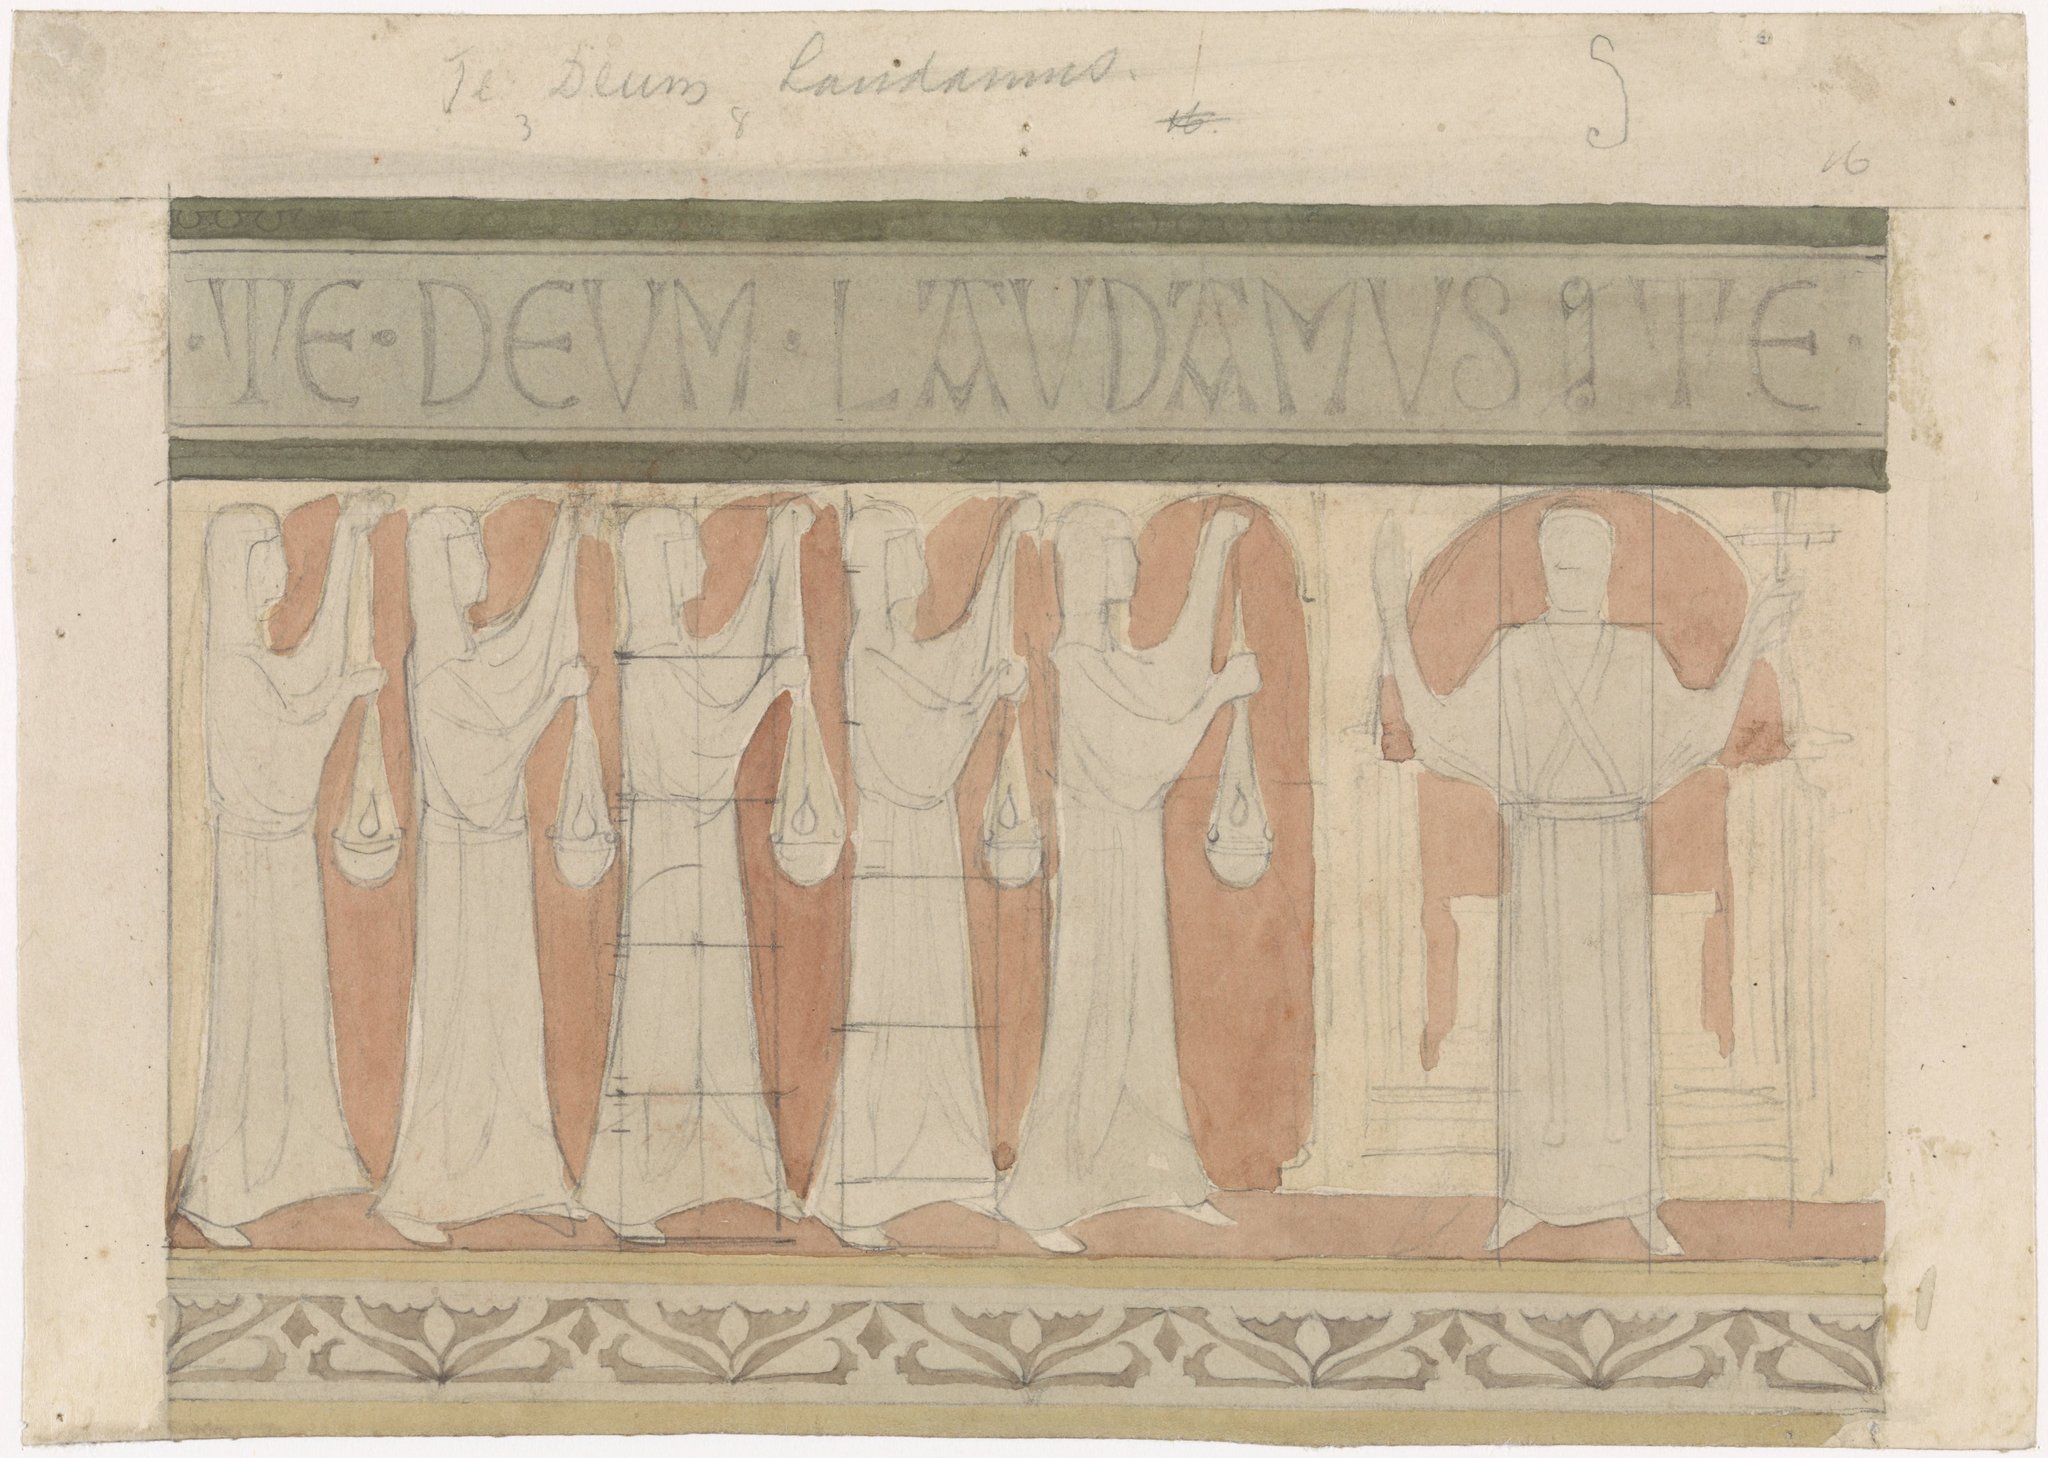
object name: design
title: De vijf wijze maagden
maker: antoon derkinderen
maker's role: draughtsman, painter, print maker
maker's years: 1859-1925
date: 1869-1925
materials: paper, pencil, watercolor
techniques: brush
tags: the wise virgins are let into the house with the bridegroom (christ); the foolish virgins are shut out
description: De tekening betreft een ontwerp voor een wandschildering.